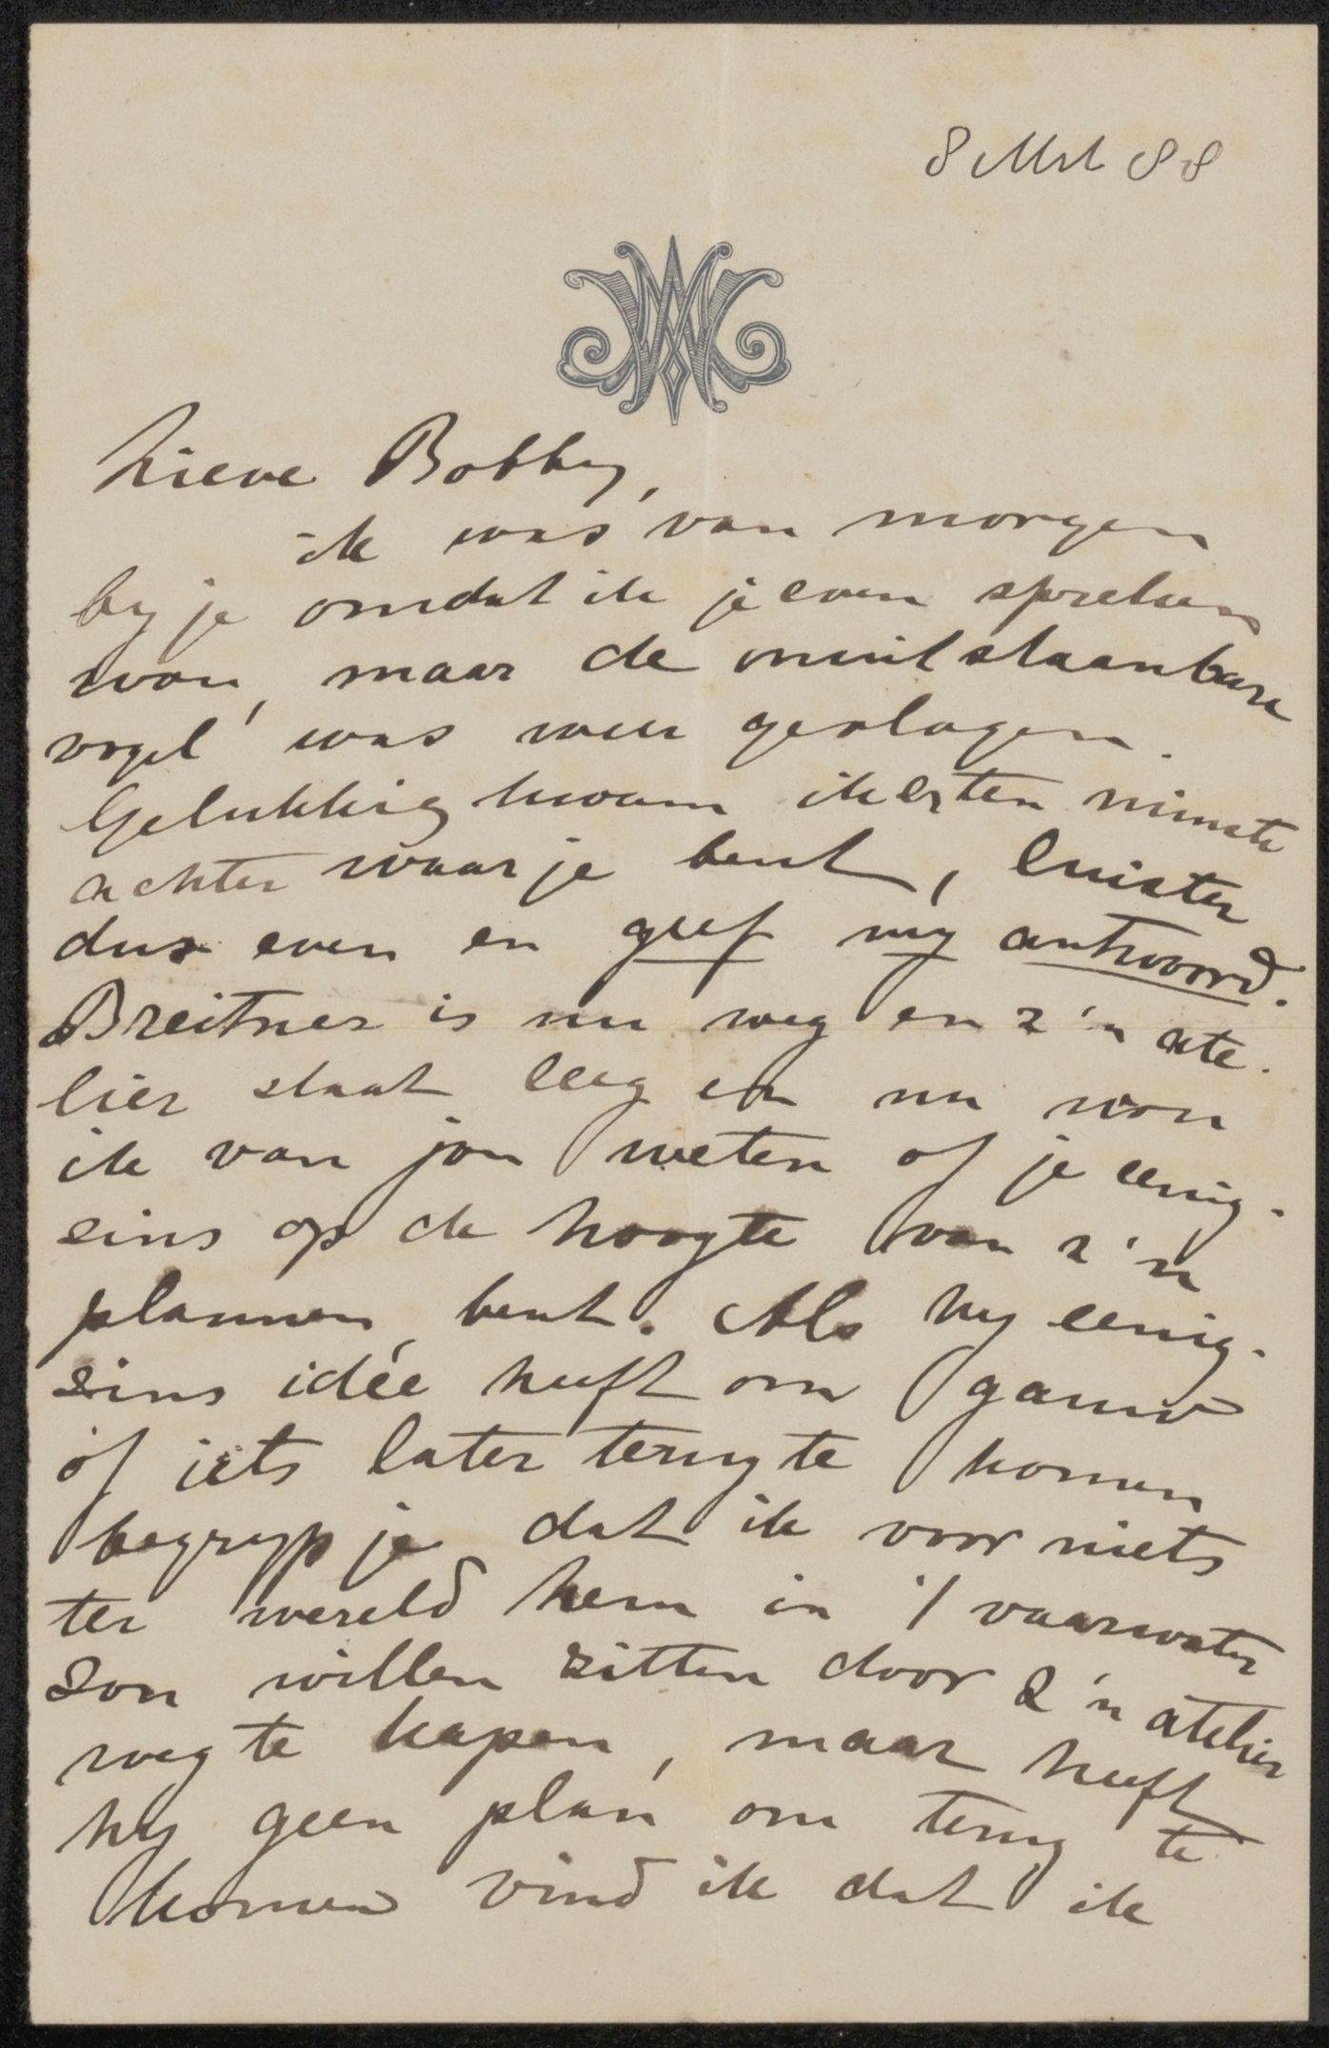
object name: letter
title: Brief aan Jan Veth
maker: wally moes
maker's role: draughtsman, print maker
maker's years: 1856-1918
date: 1874-1918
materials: ink, paper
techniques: pen, writing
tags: rotterdam, george hendrik breitner, painter, jan veth, workshop, studio of the artist (in general)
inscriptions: collector's mark: ‘RPK’